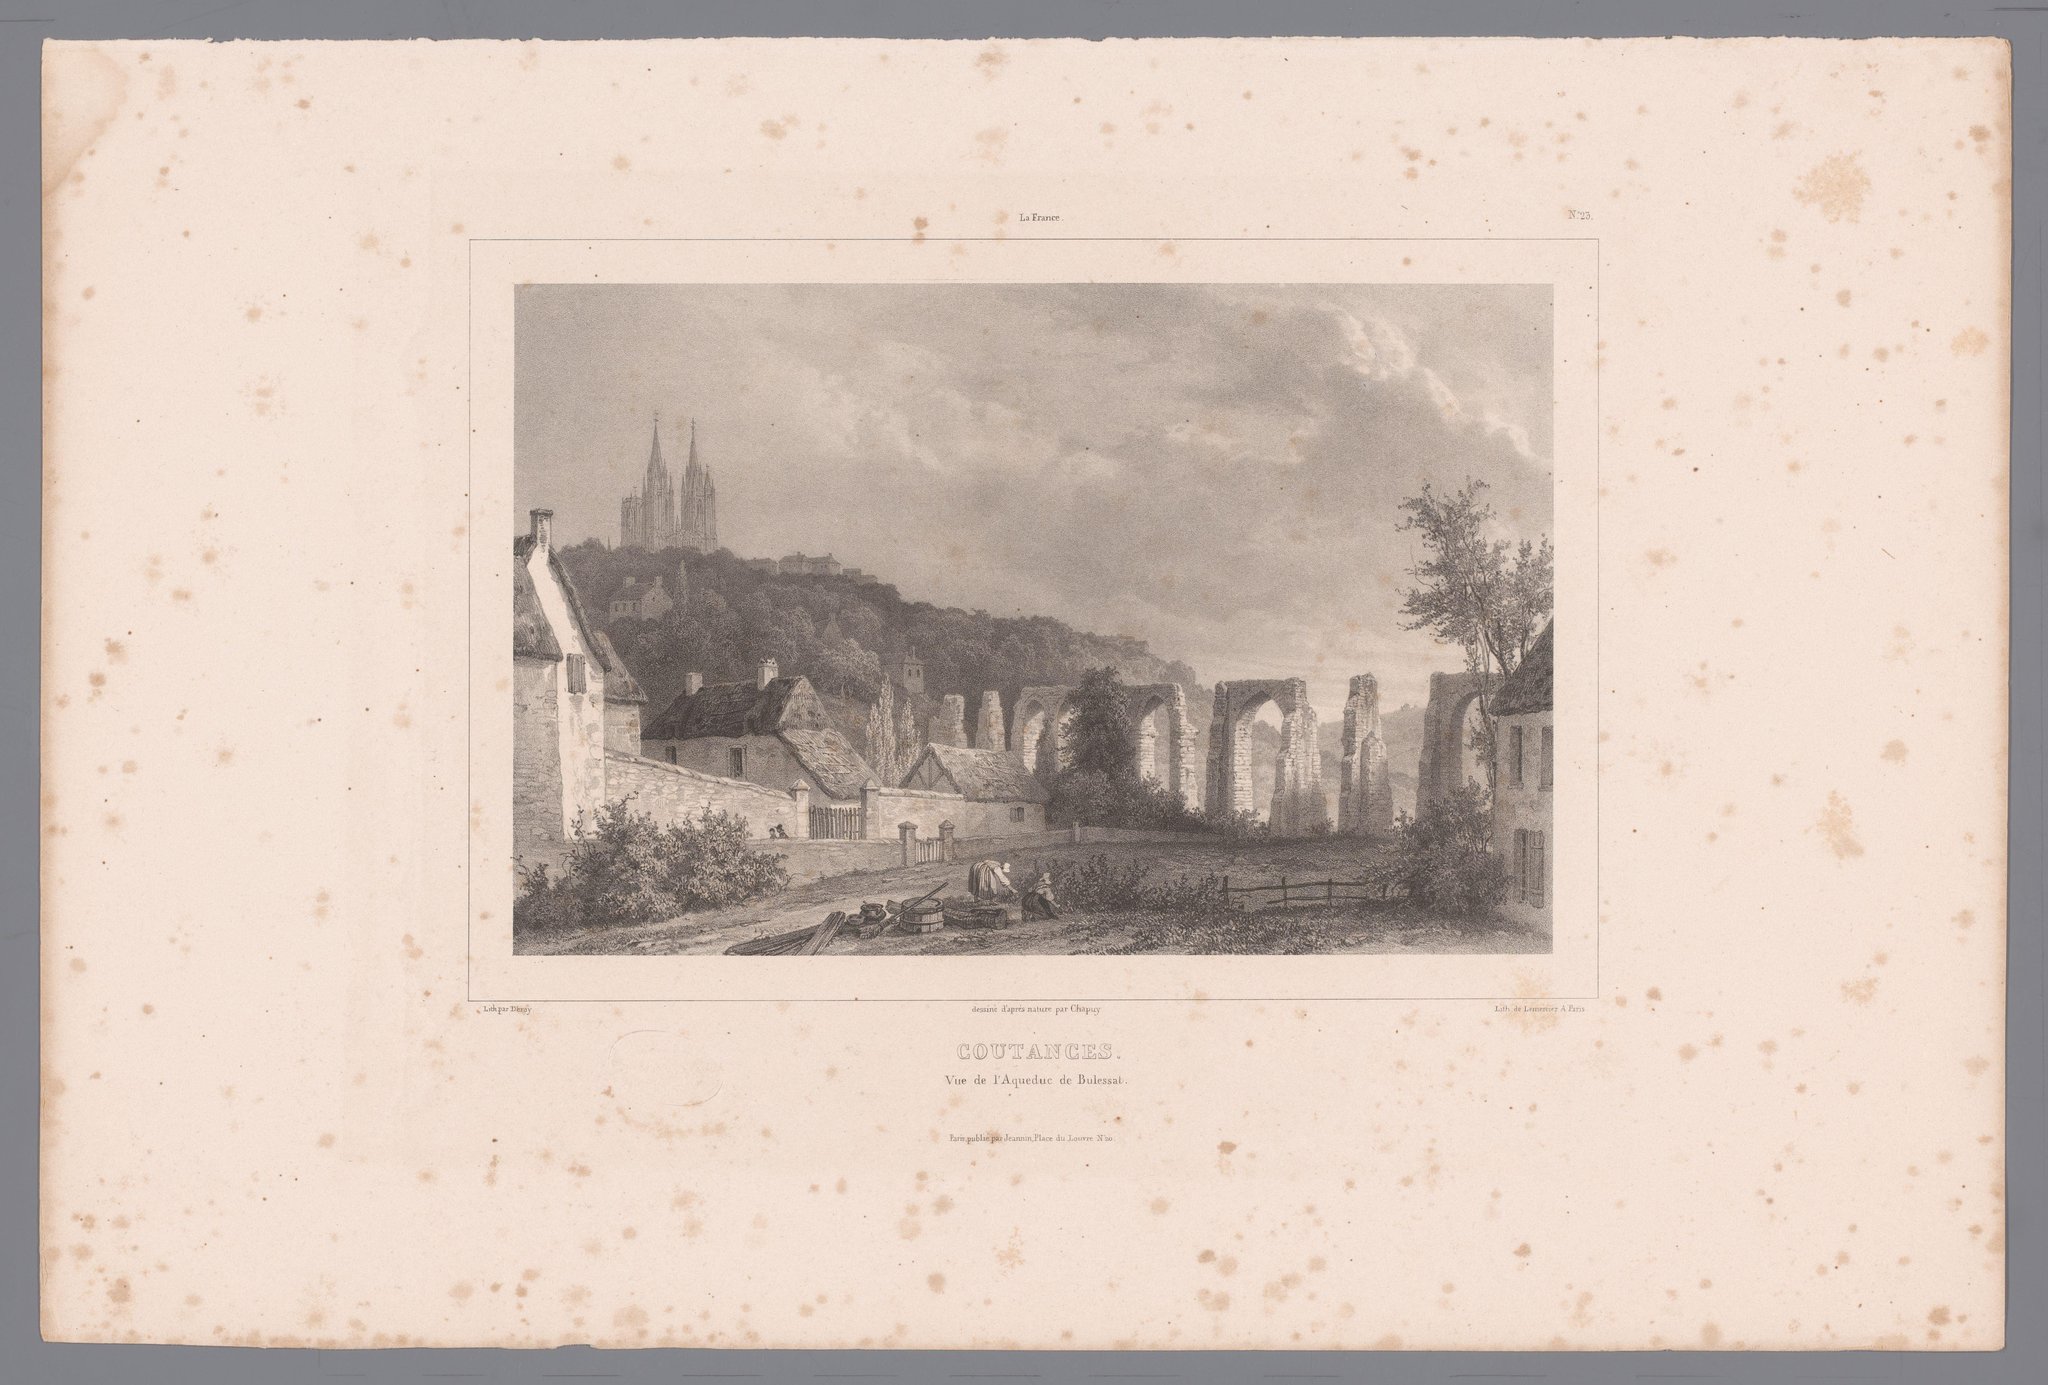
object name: print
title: Gezichten in Frankrijk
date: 1834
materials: paper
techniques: lithograph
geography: paris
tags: landscape with bridge, viaduct or aqueduct (+ city(-scape) with figures, staffage)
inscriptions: collector's mark: Lugt 2228a, check stamp: Lugt 1397c